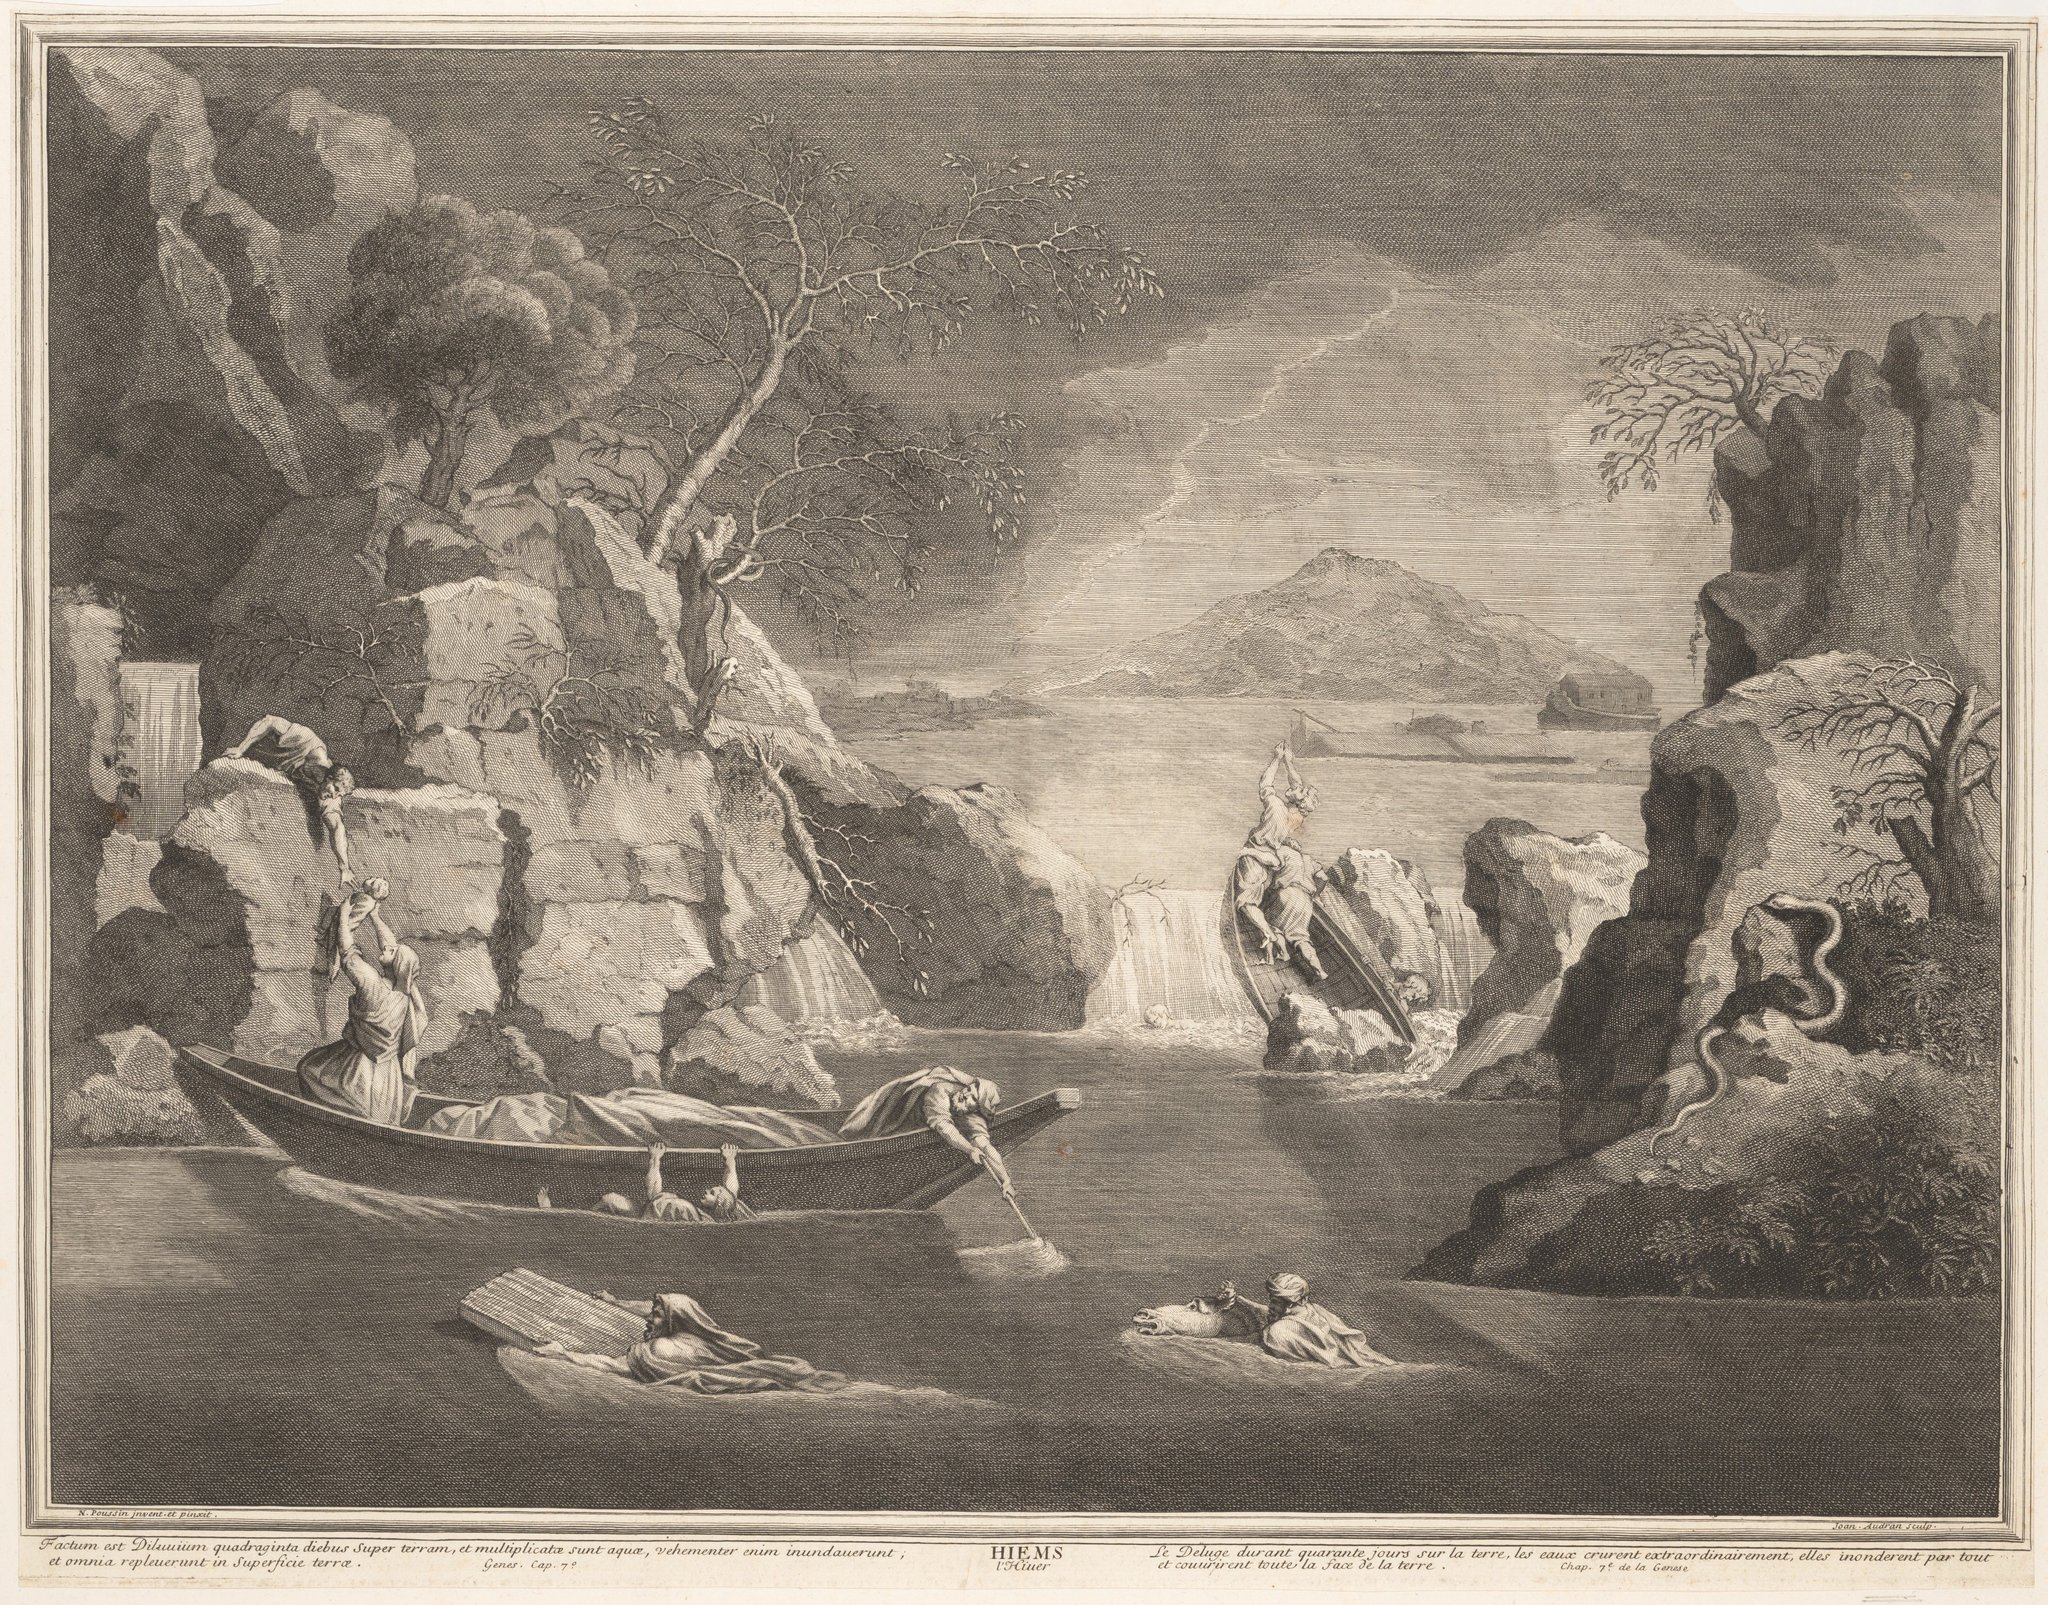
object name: print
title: Winter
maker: nicolas poussin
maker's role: artist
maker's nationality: french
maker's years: 1594-1665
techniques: engraving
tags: infants,women,horses,snakes,winter,boats